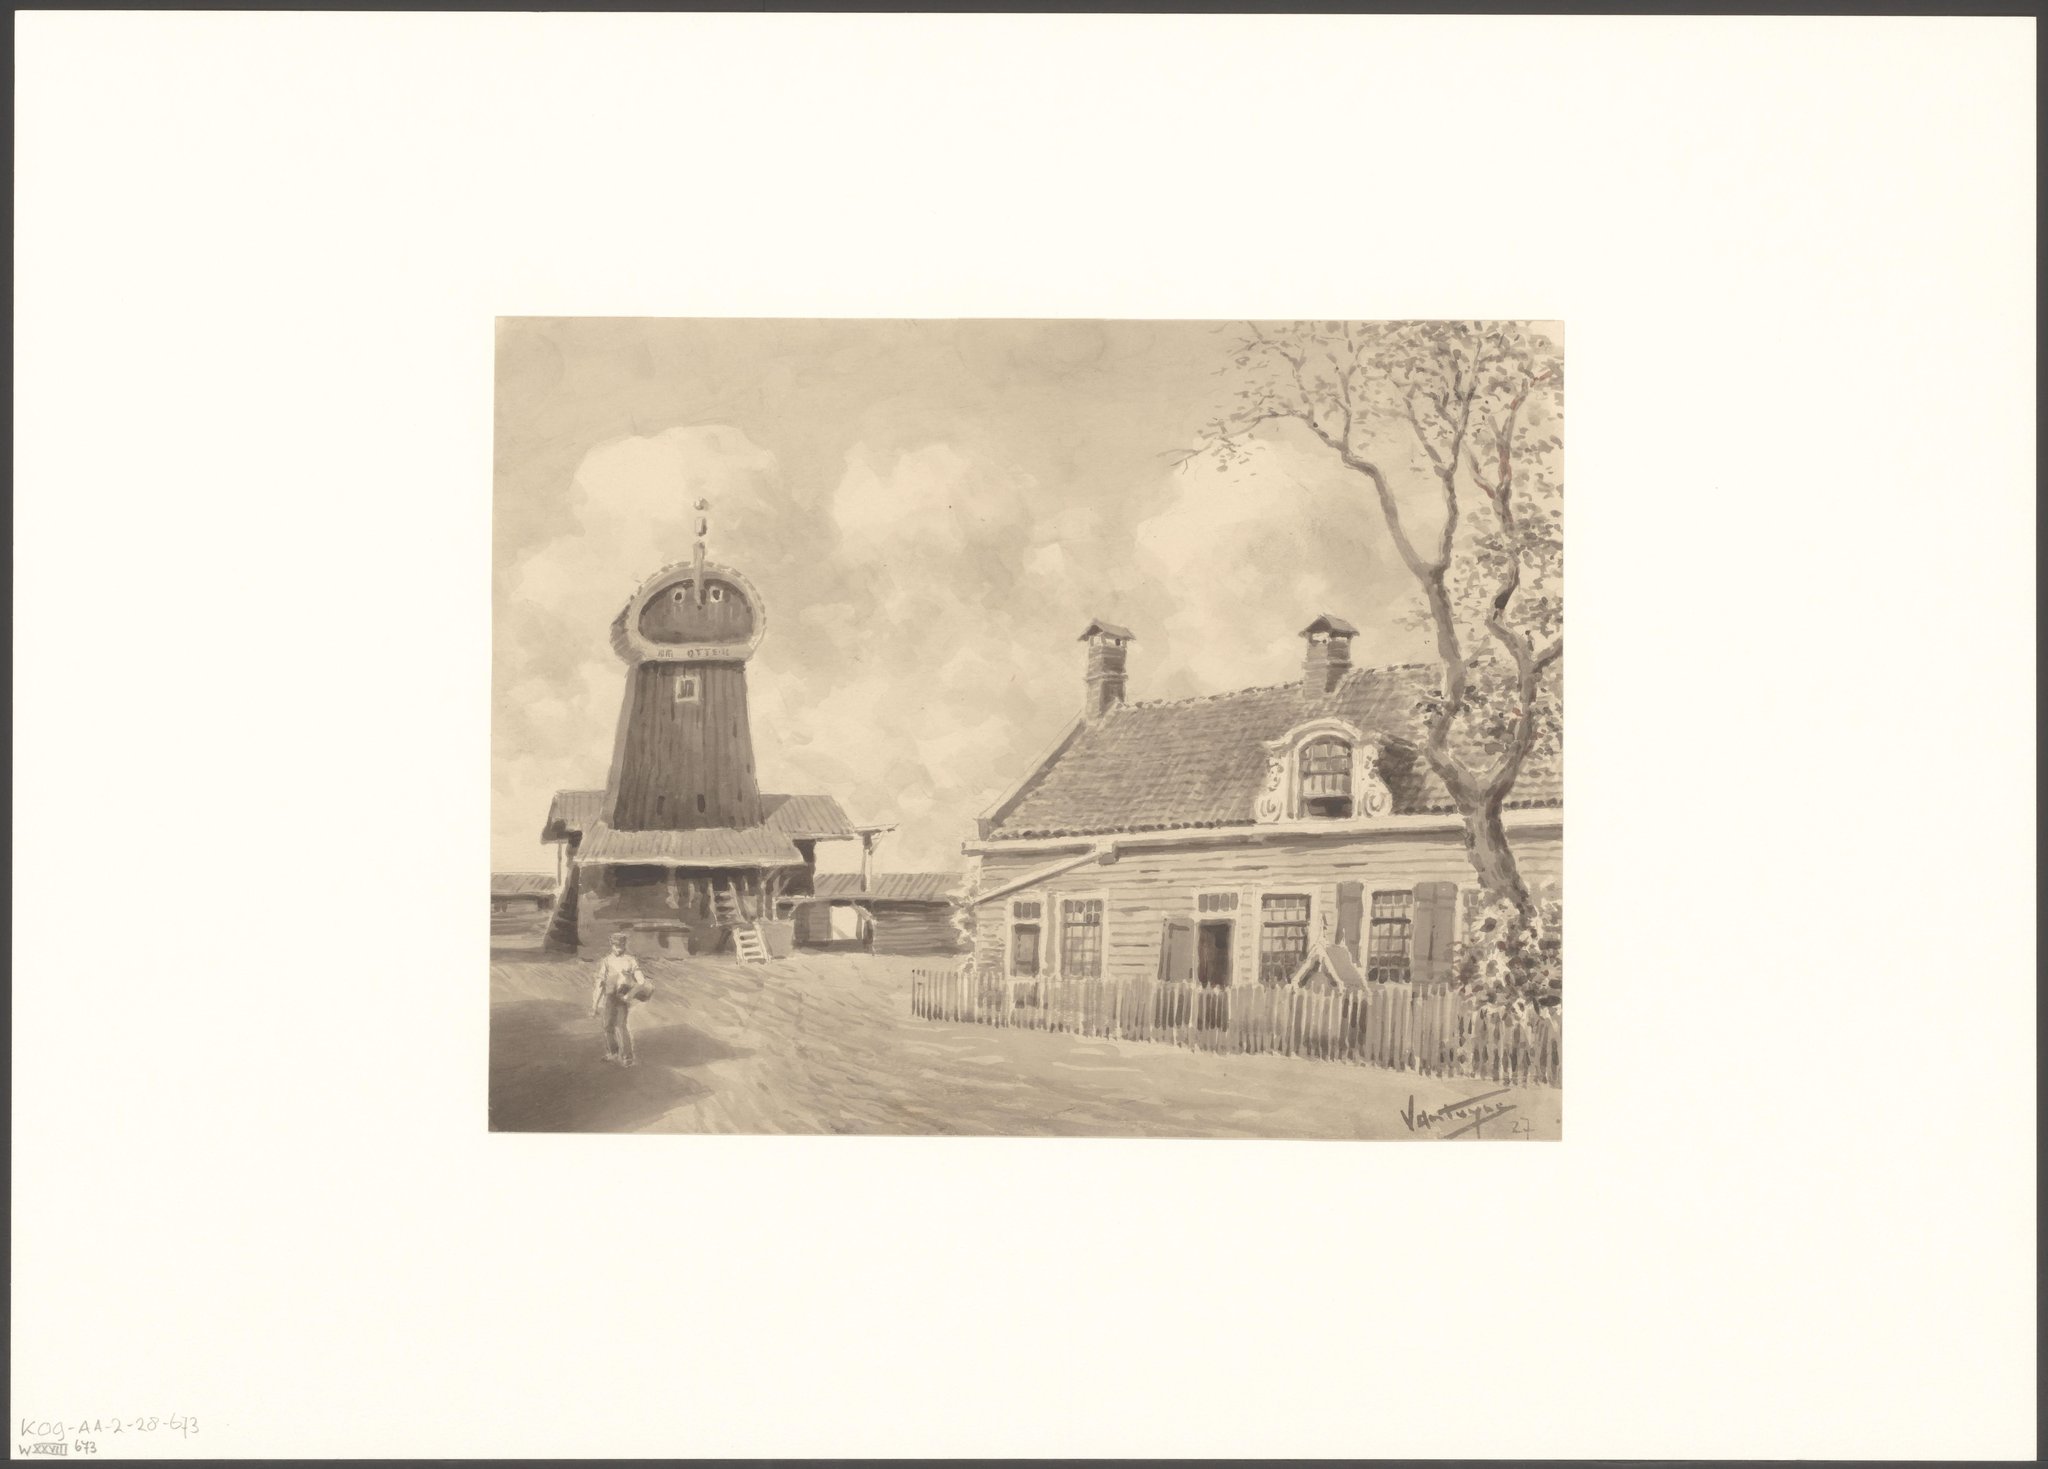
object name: drawing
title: Gezicht op de werf van molen De Otter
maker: anthonie van teijn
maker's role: draughtsman, painter, print maker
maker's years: 1863-1943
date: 1907-1927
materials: ink, paper, pencil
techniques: brush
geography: amsterdam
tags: city-view in general; 'veduta', windmill in landscape, pier, quay, wharf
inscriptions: signature and date: ‘VanTeyne / 27’, collector's mark: Lugt 800a, inscription: ‘Werf van de (...) Juli 1927. / vEck’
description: Tekening binnen de Atlas Van Eck ingedeeld op wijknummer 28.